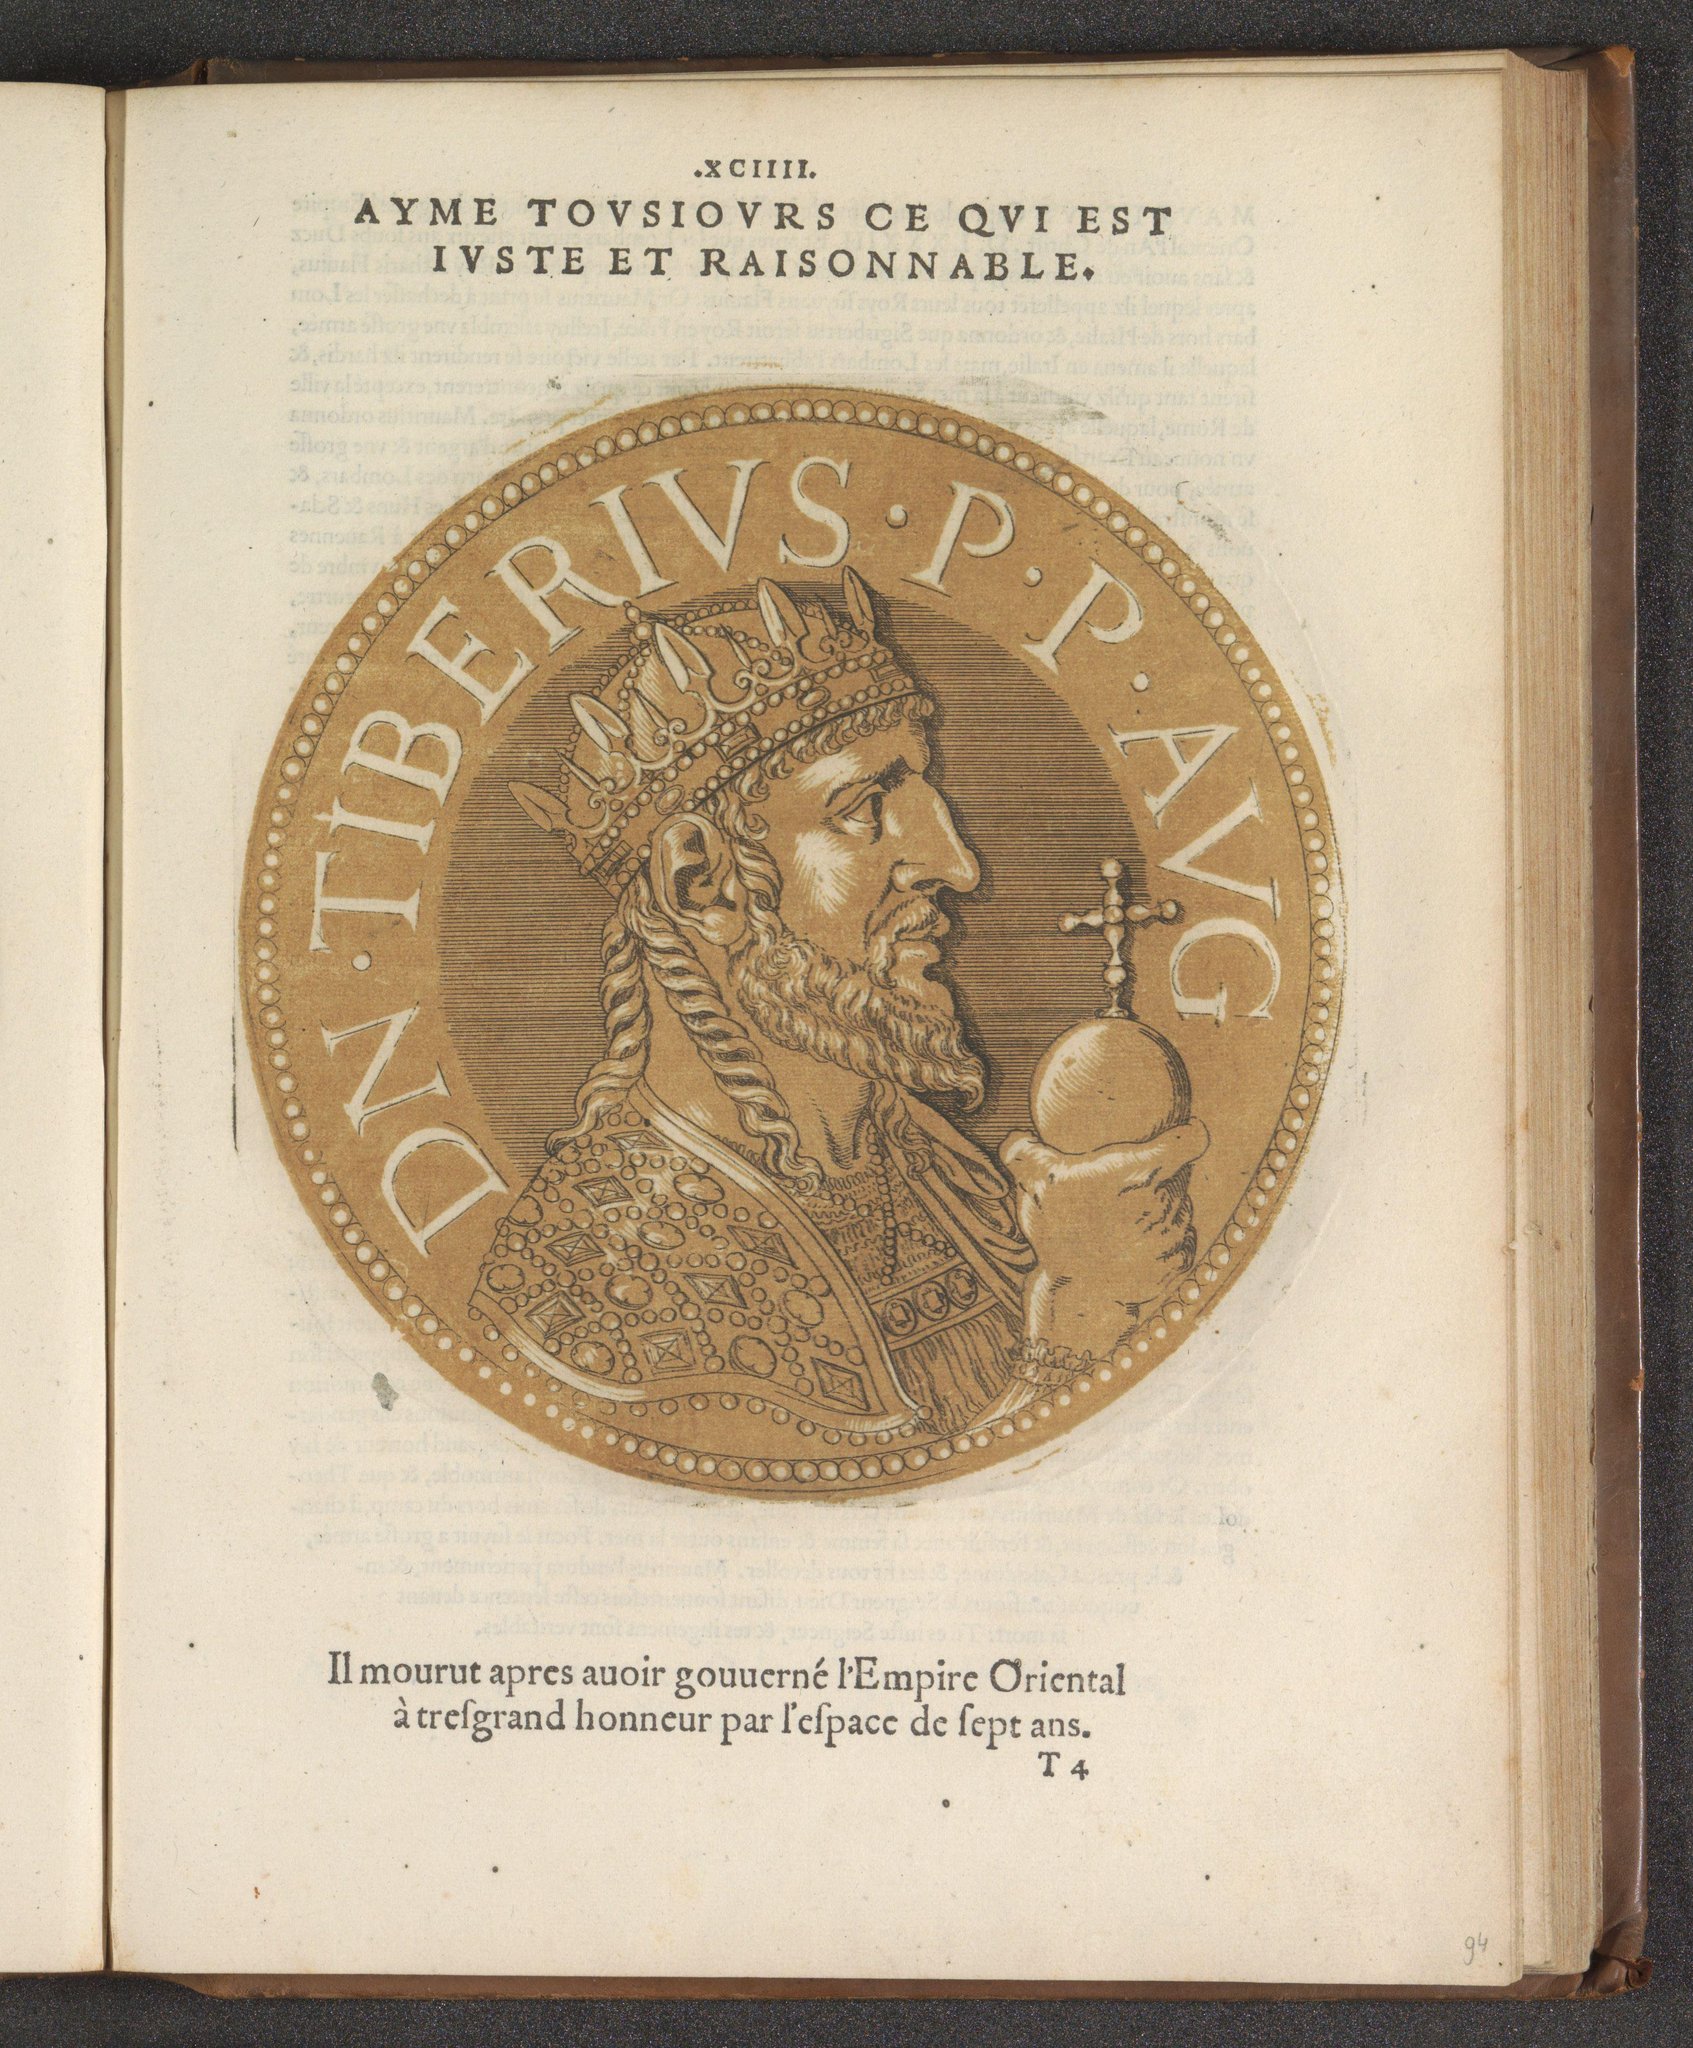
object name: print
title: Portret van keizer Tiberius II Constantijn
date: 1557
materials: paper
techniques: woodcut, etching, letterpress printing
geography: antwerp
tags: emperor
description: Portret van keizer Tiberius II Constantijn, op een munt met randschrift. De prent maakt deel uit van een boek over de keizers vanaf Julius Caesar tot en met Karel V en zijn broer Ferdinand.